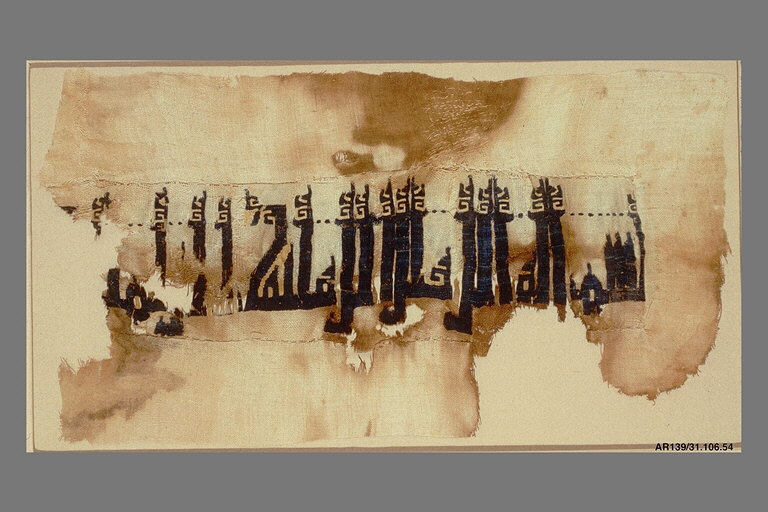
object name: tiraz fragment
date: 901-1000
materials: linen, silk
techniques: weave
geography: egypt